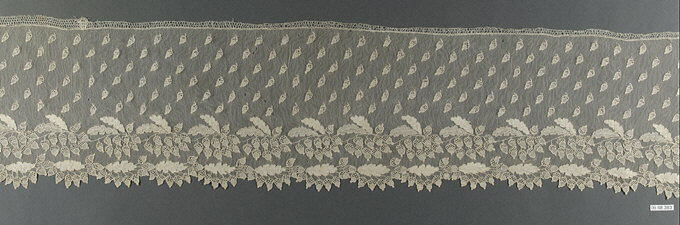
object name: border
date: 1801-1900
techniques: lace